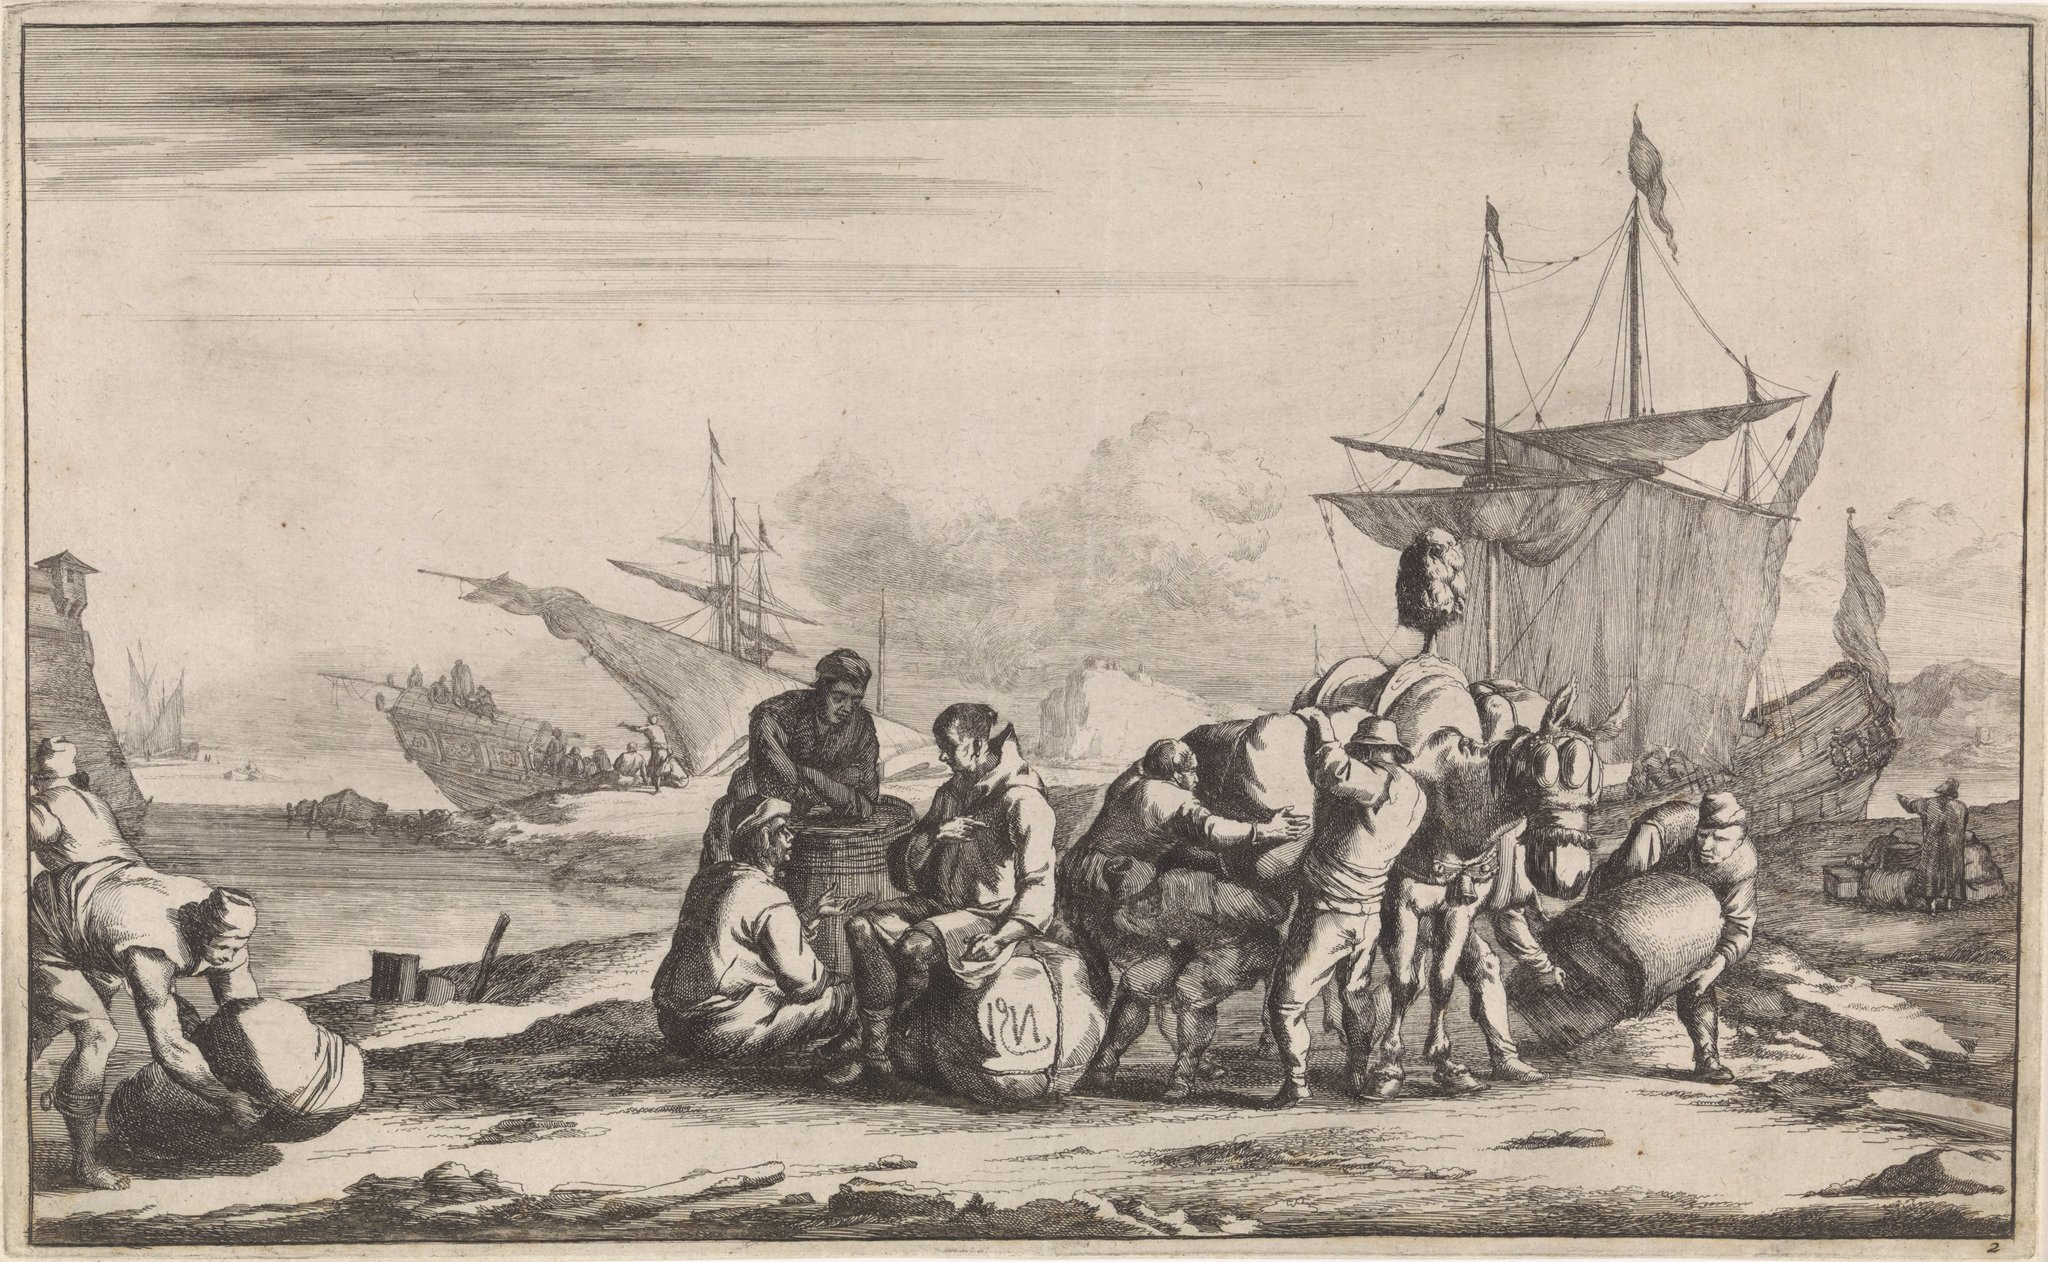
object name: print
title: Havens van Genua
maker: anthony van zijlvelt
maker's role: print maker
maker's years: 1637-1715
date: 1650-1695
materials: paper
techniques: etching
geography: amsterdam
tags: harbour, sailing-ship, sailing-boat, ass, donkey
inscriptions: collector's mark: Lugt 240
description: In de haven van Genua spreken drie mensen met elkaar bij een ton. Een aantal mannen beladen een pakezel. Op de achtergrond schepen.